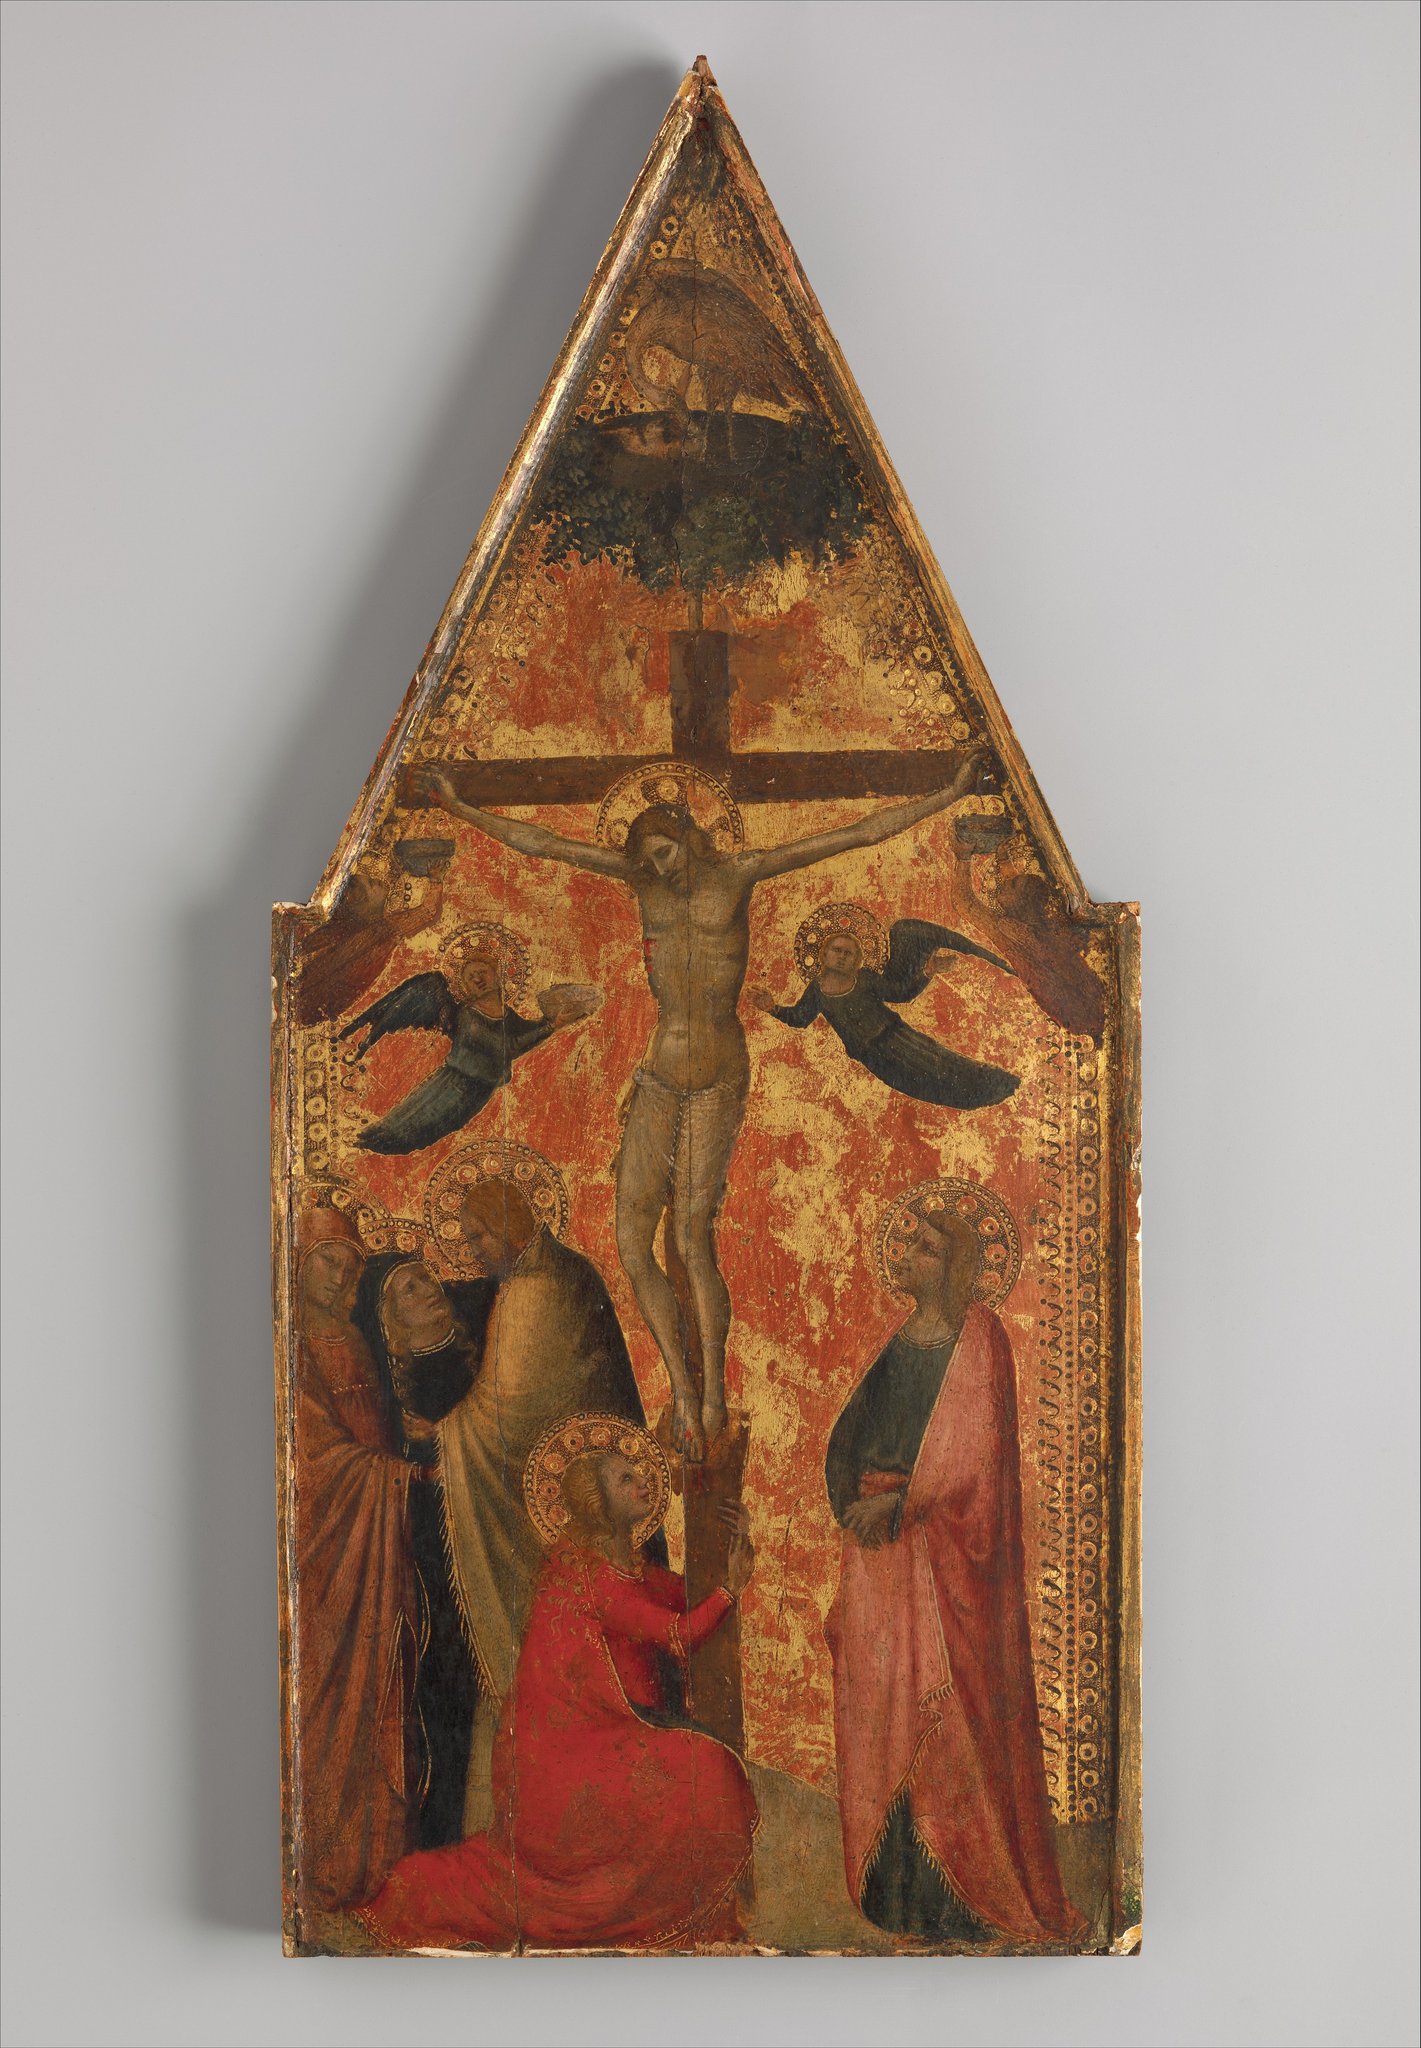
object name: triptych or diptych panel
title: The Crucifixion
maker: allegretto di nuzio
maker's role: artist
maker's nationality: italian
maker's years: 1315-1374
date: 1345-1374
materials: gold leaf, paint, wood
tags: crucifixion